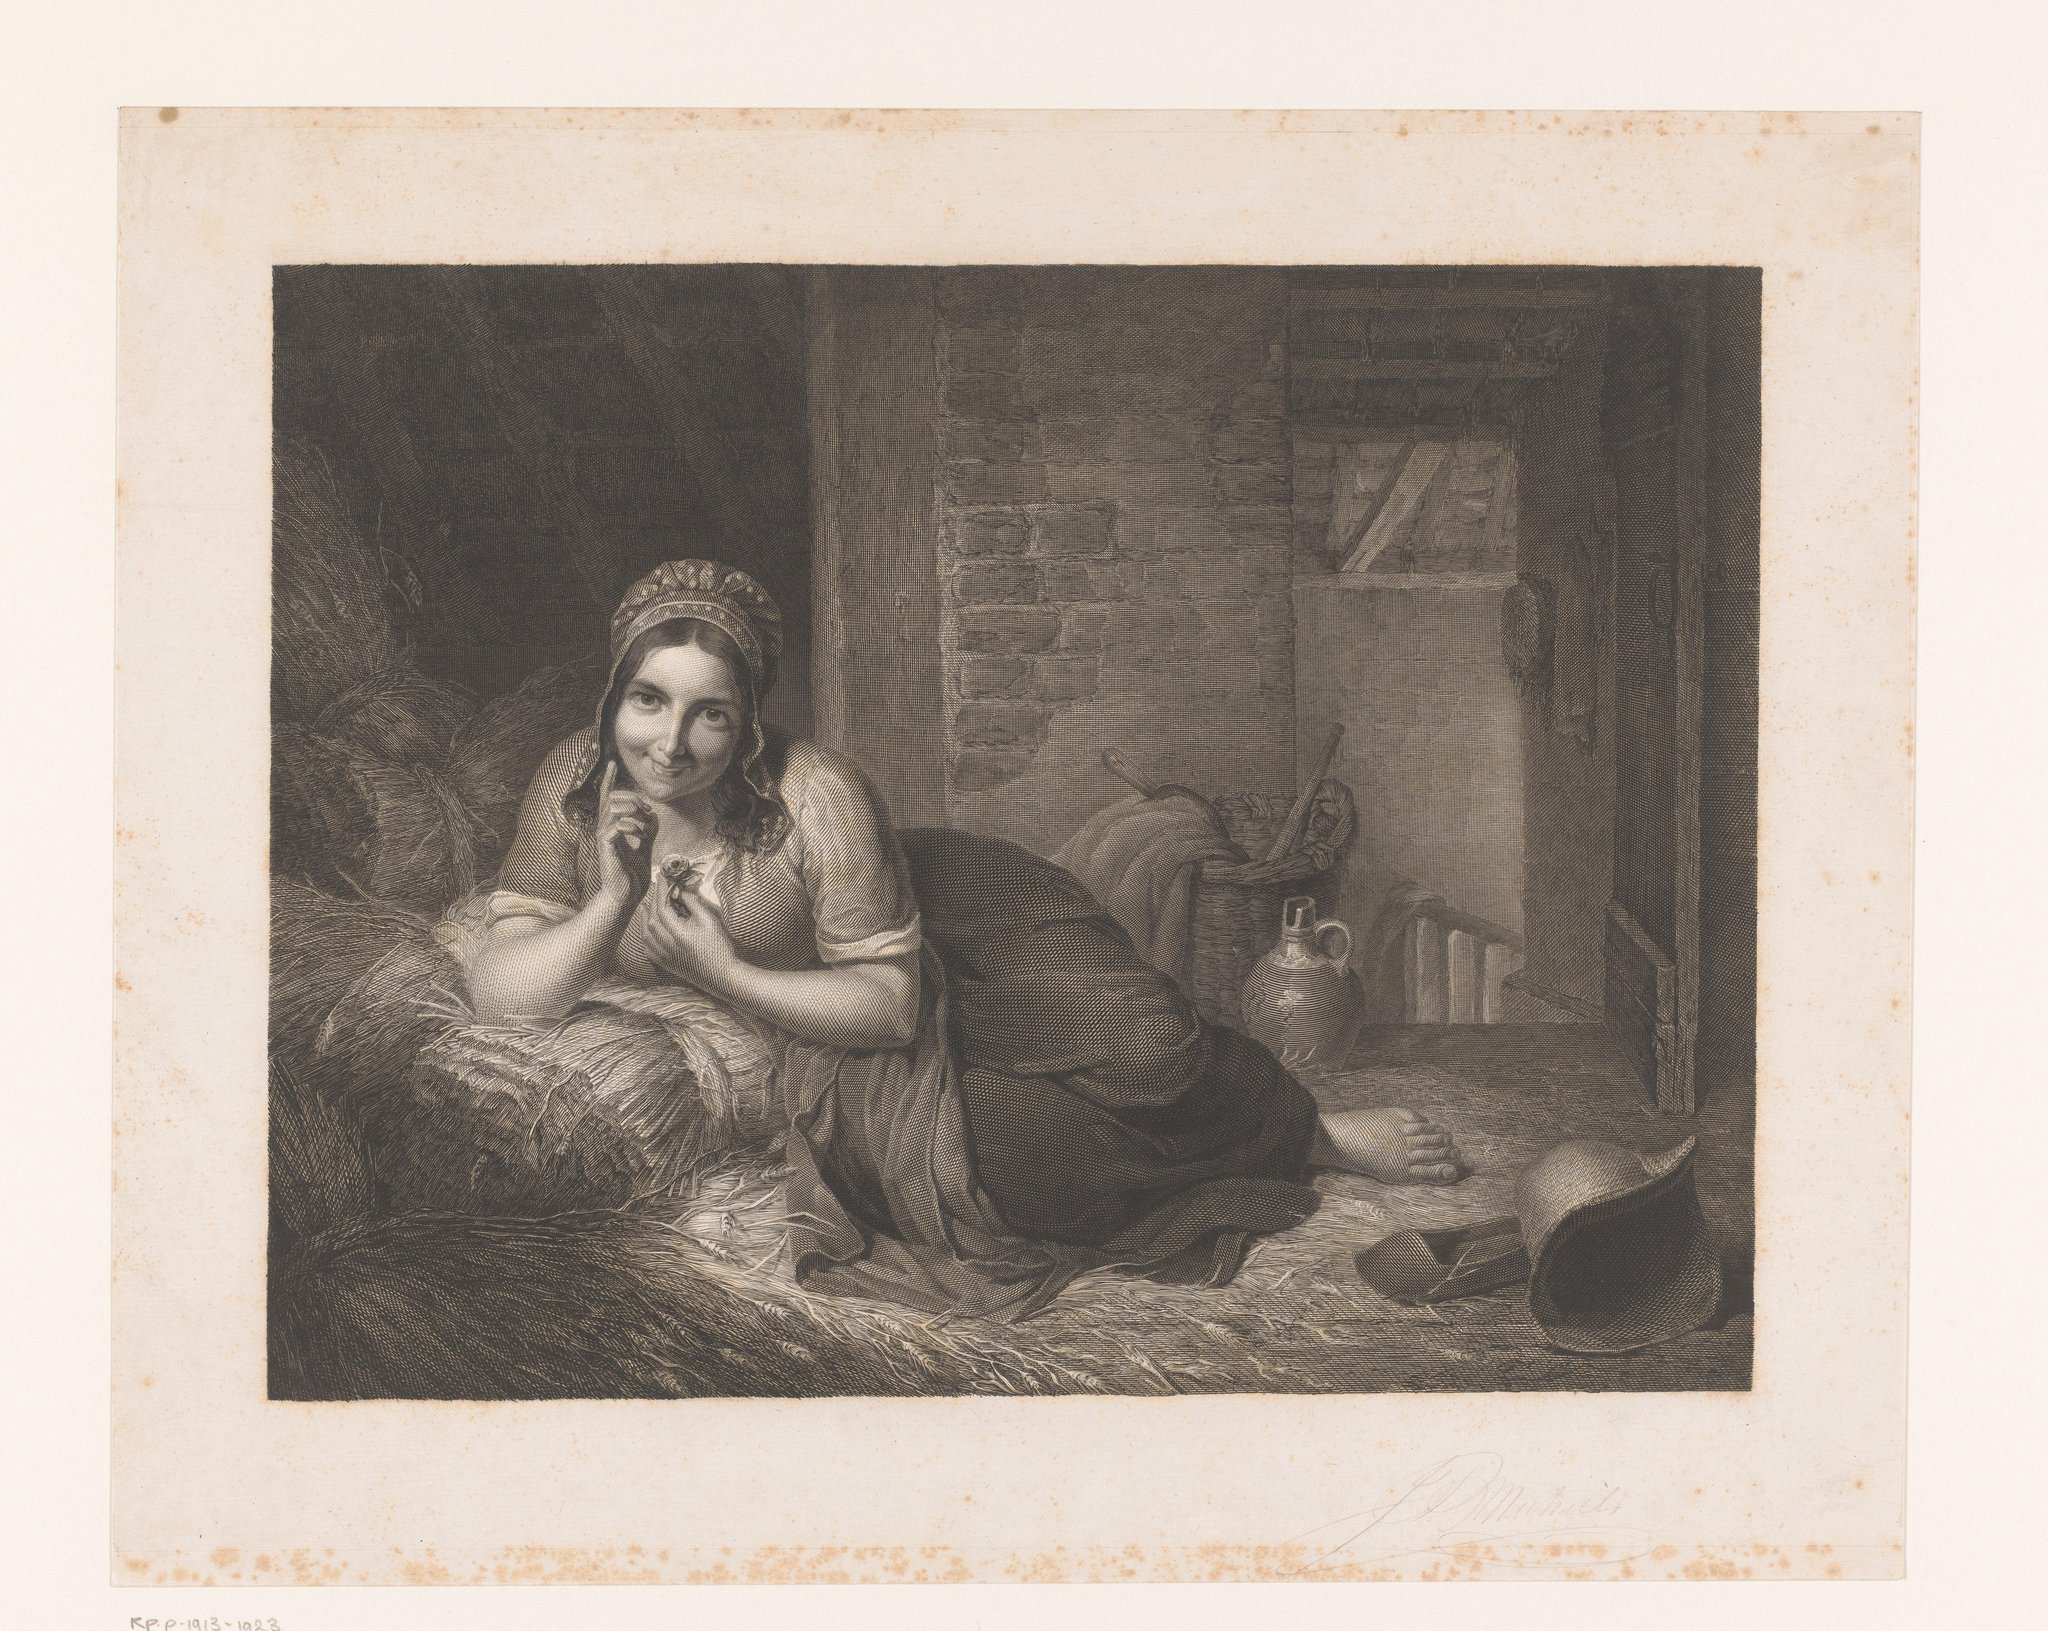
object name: print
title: Jonge vrouw liggend in het hooi op een zolder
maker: jean baptiste pierre michiels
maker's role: print maker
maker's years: 1821-1890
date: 1831-1890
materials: paper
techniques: engraving, etching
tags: adolescent, young woman, maiden, agricultural products and by-products: hay, attic, loft, flowers: rose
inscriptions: collector's mark: Lugt 2228